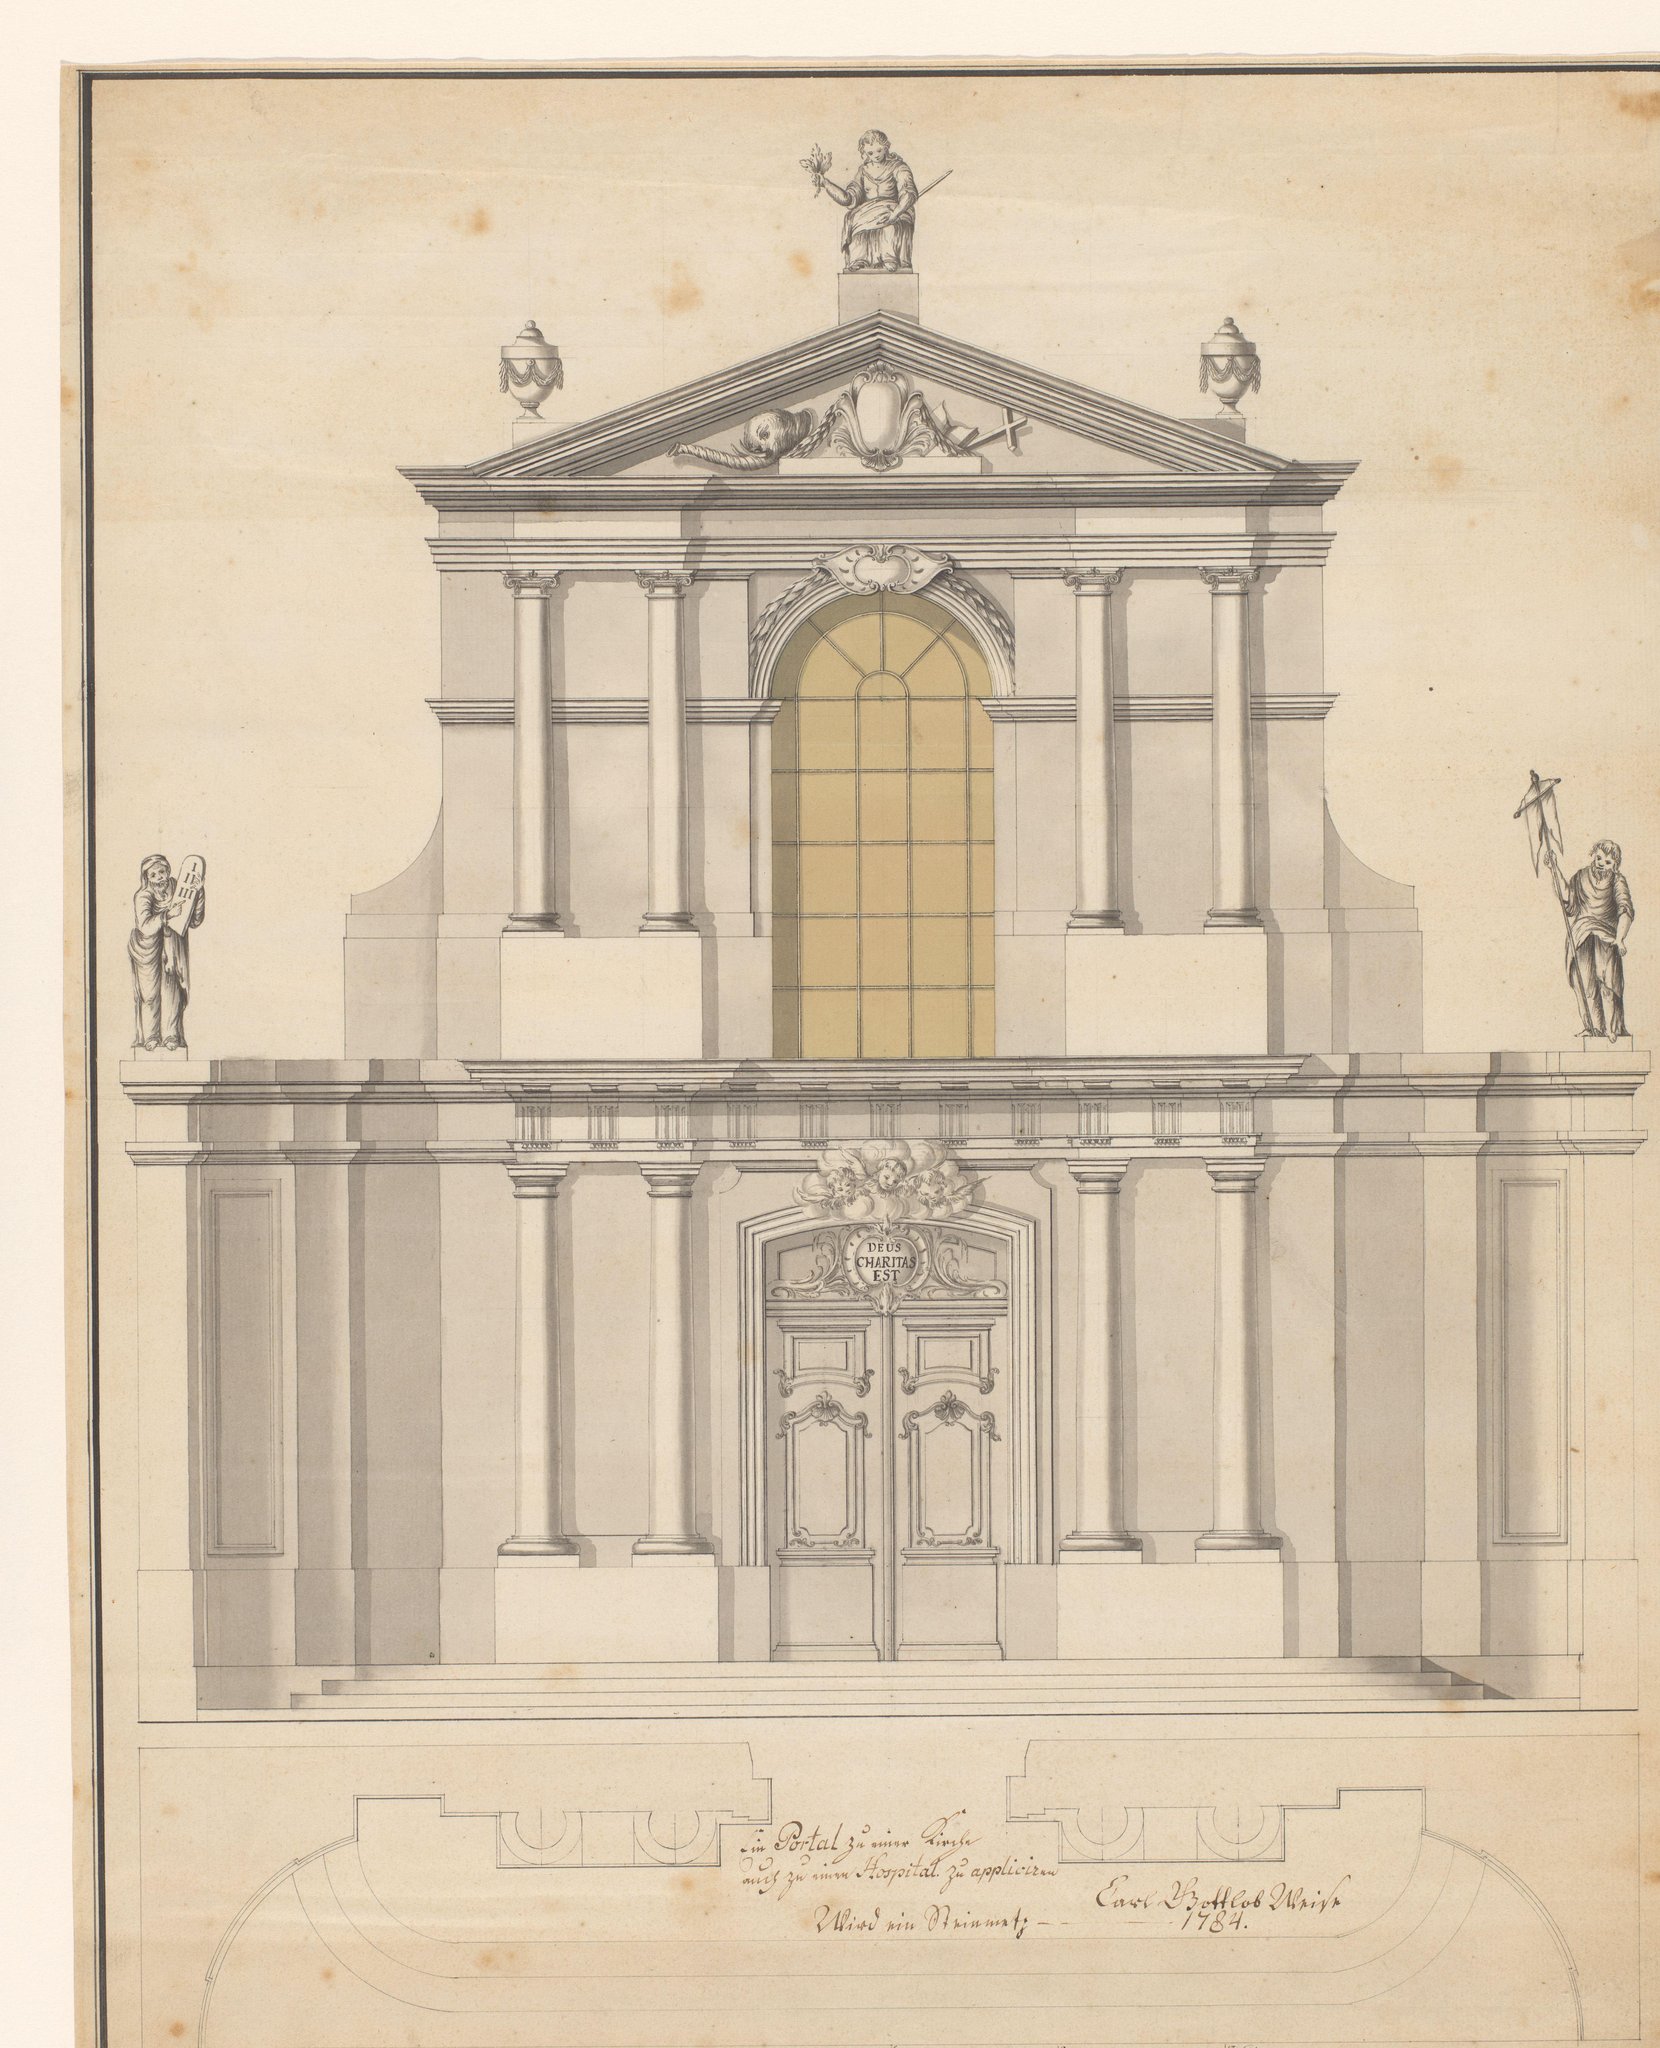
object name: drawing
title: Ontwerp voor de ingangspartij van een kerk, met eronder een plattegrond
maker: carl gottlob weise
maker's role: draughtsman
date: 1784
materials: graphite, ink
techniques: drawing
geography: germany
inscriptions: watermark: ‘D&C BLAUW’, inscription: ‘Ein Portal zu einer Kirche / auch zu einen Hospital. Zu appliciren / Carl Gottlob Weise / 1784. / Wird ein Steinmetz. Op de tafel die de figuur van Mozes ophoudt: I / II / III. In een cartouche boven de dubbele deur: DEUS / CHARITAS / EST.’, size: ‘Maatverdeling met: ½ 1 2 3 4 5 6 7 8 9 10 Ellen.’, watermark: ‘Contramerk: wapen met dubbele balk (Strasburg bend) met daarboven een lelie.’